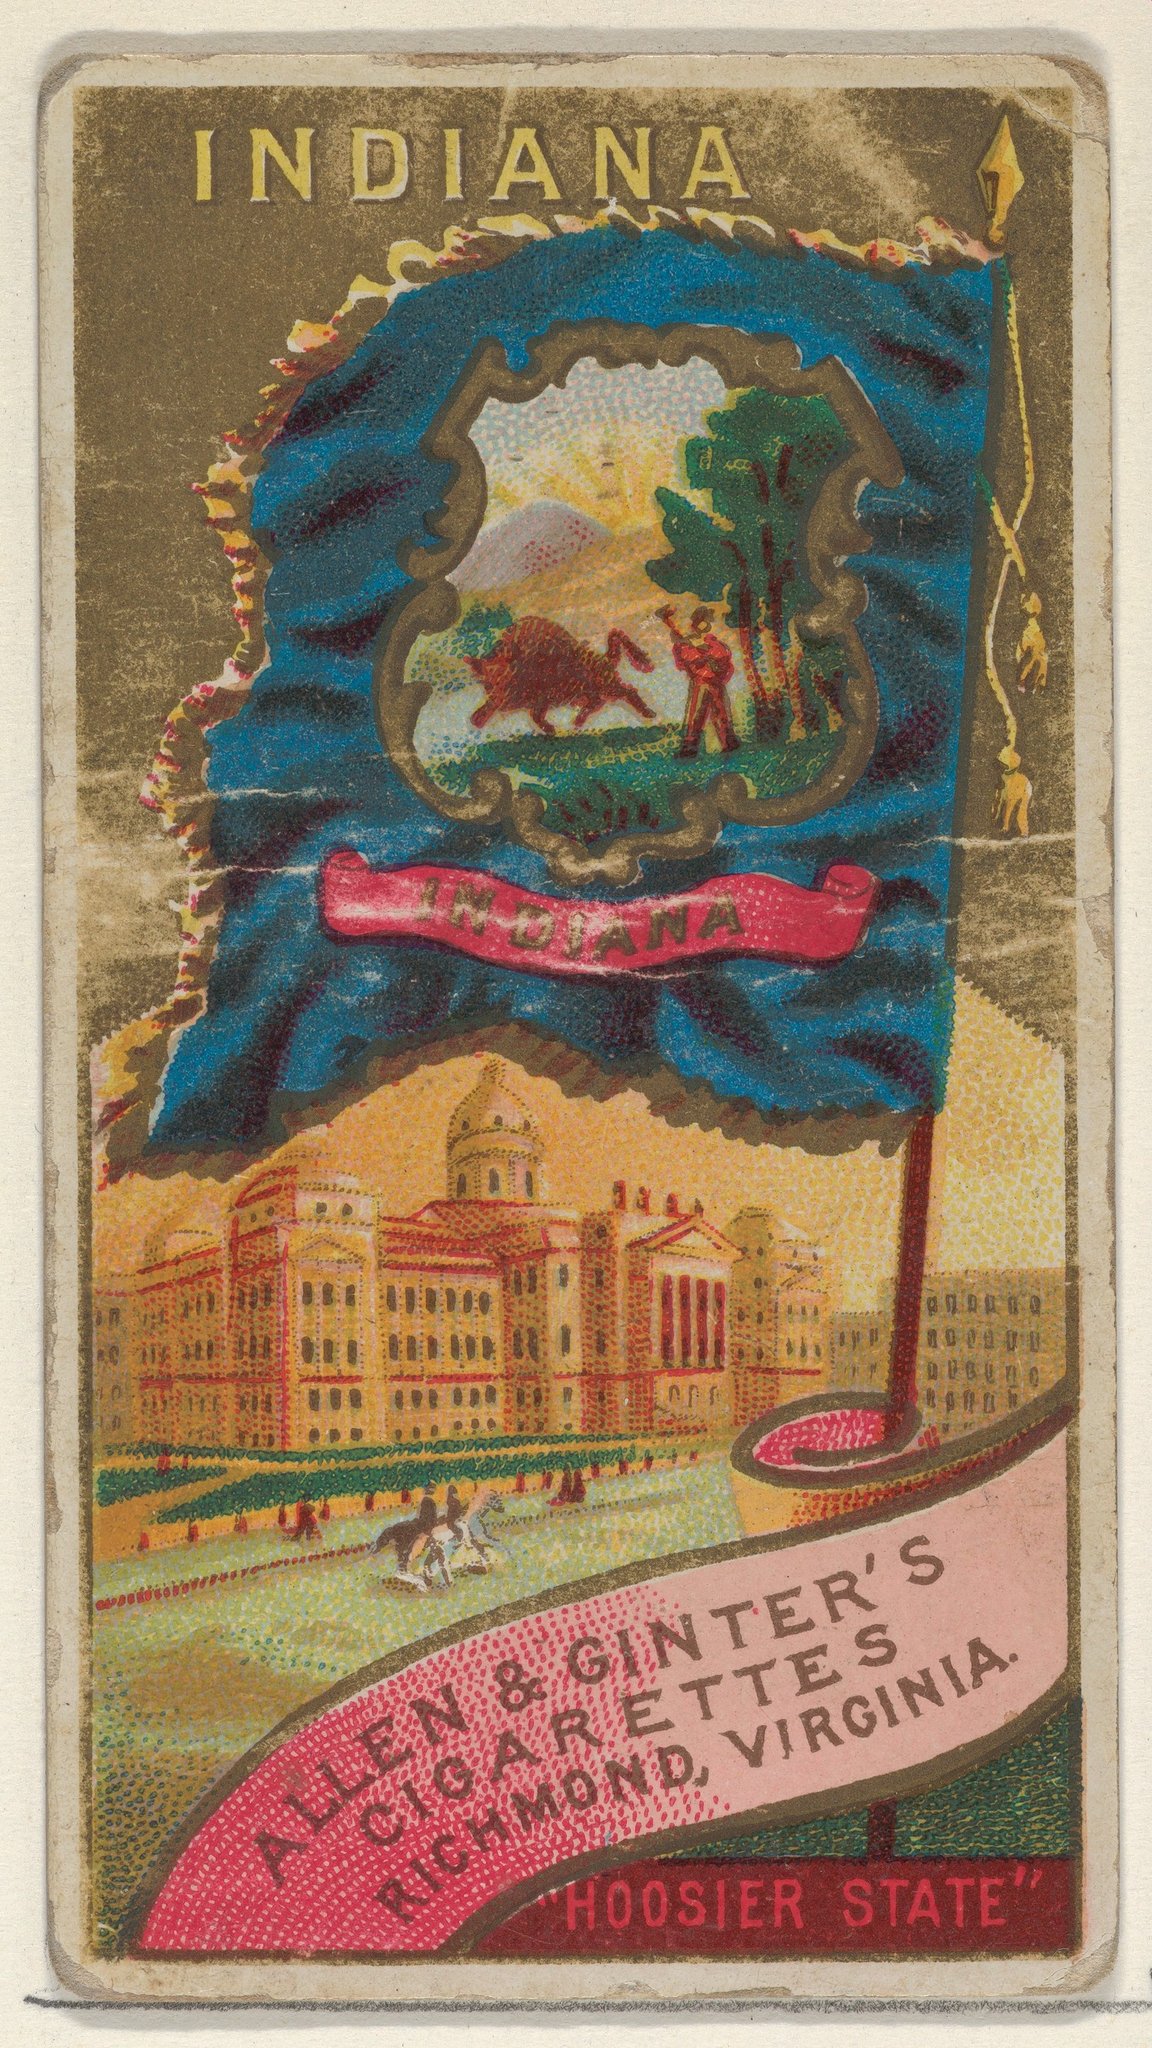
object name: print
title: Indiana, from Flags of the States and Territories (N11) for Allen & Ginter Cigarettes Brands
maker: allen & ginter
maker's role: publisher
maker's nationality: american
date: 1888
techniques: color lithograph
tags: flags